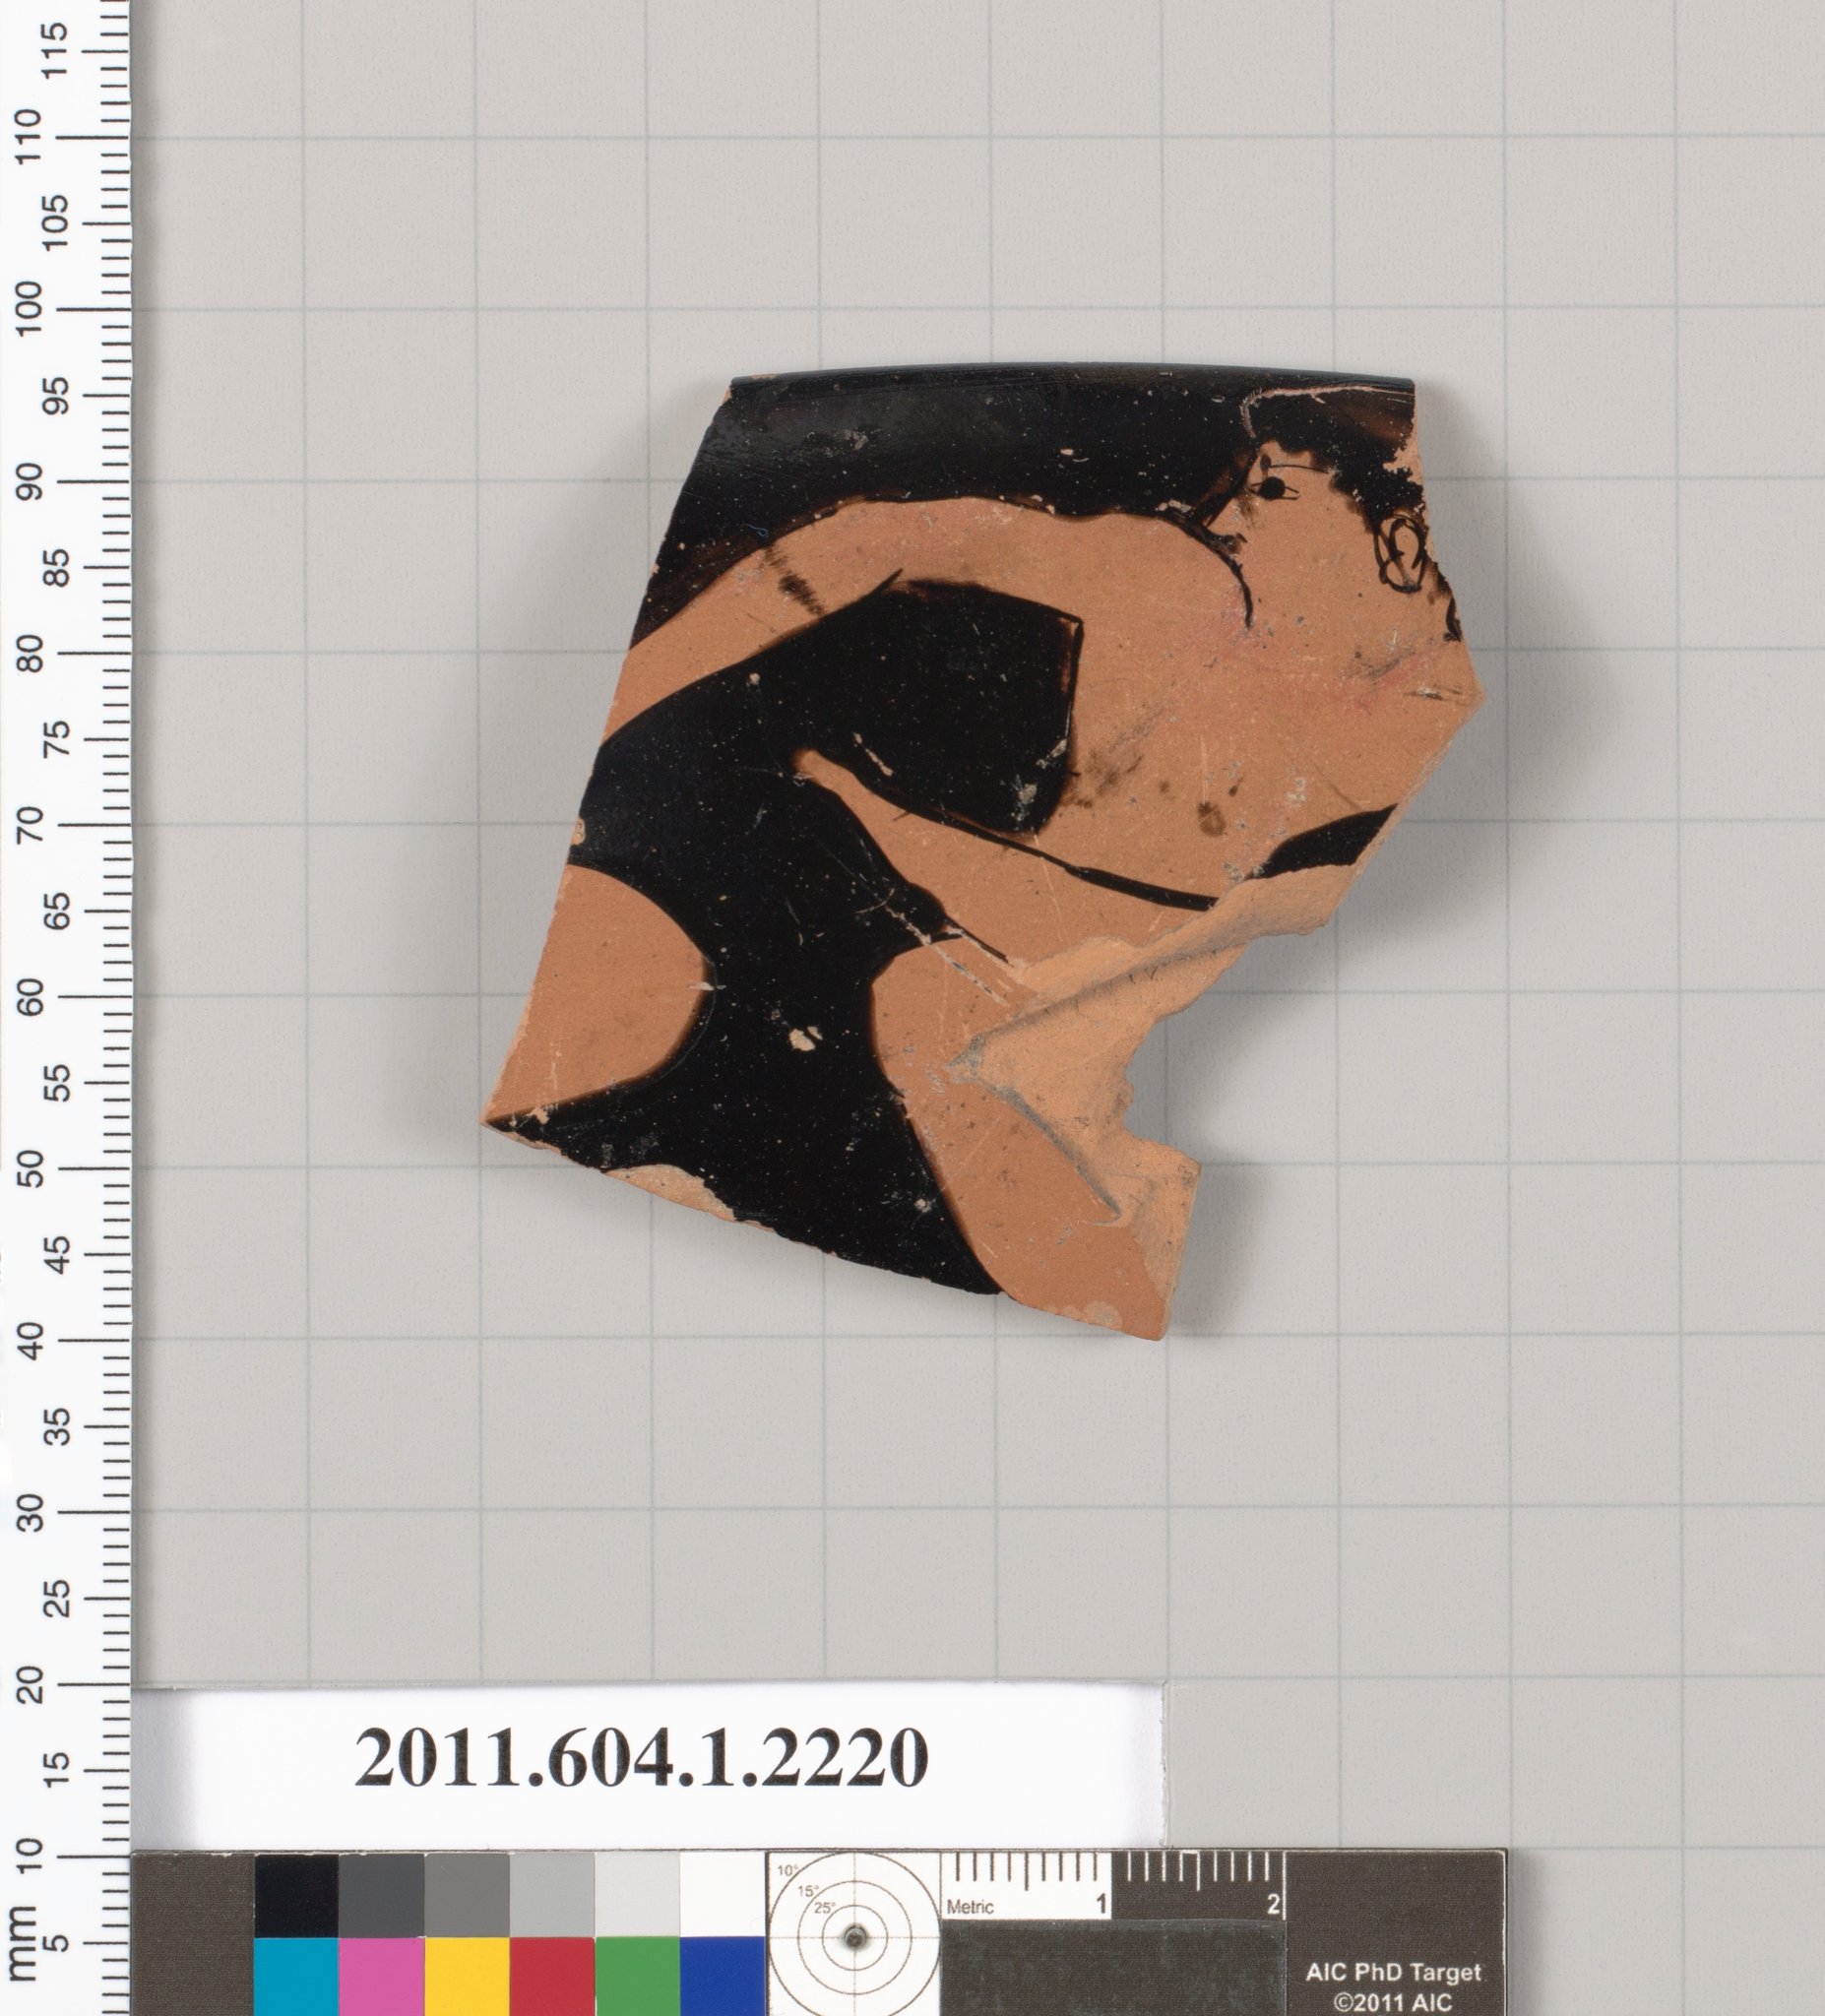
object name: kylix fragment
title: Terracotta rim fragment of a kylix (drinking cup)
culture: greek, attic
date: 534-468 BCE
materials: terracotta